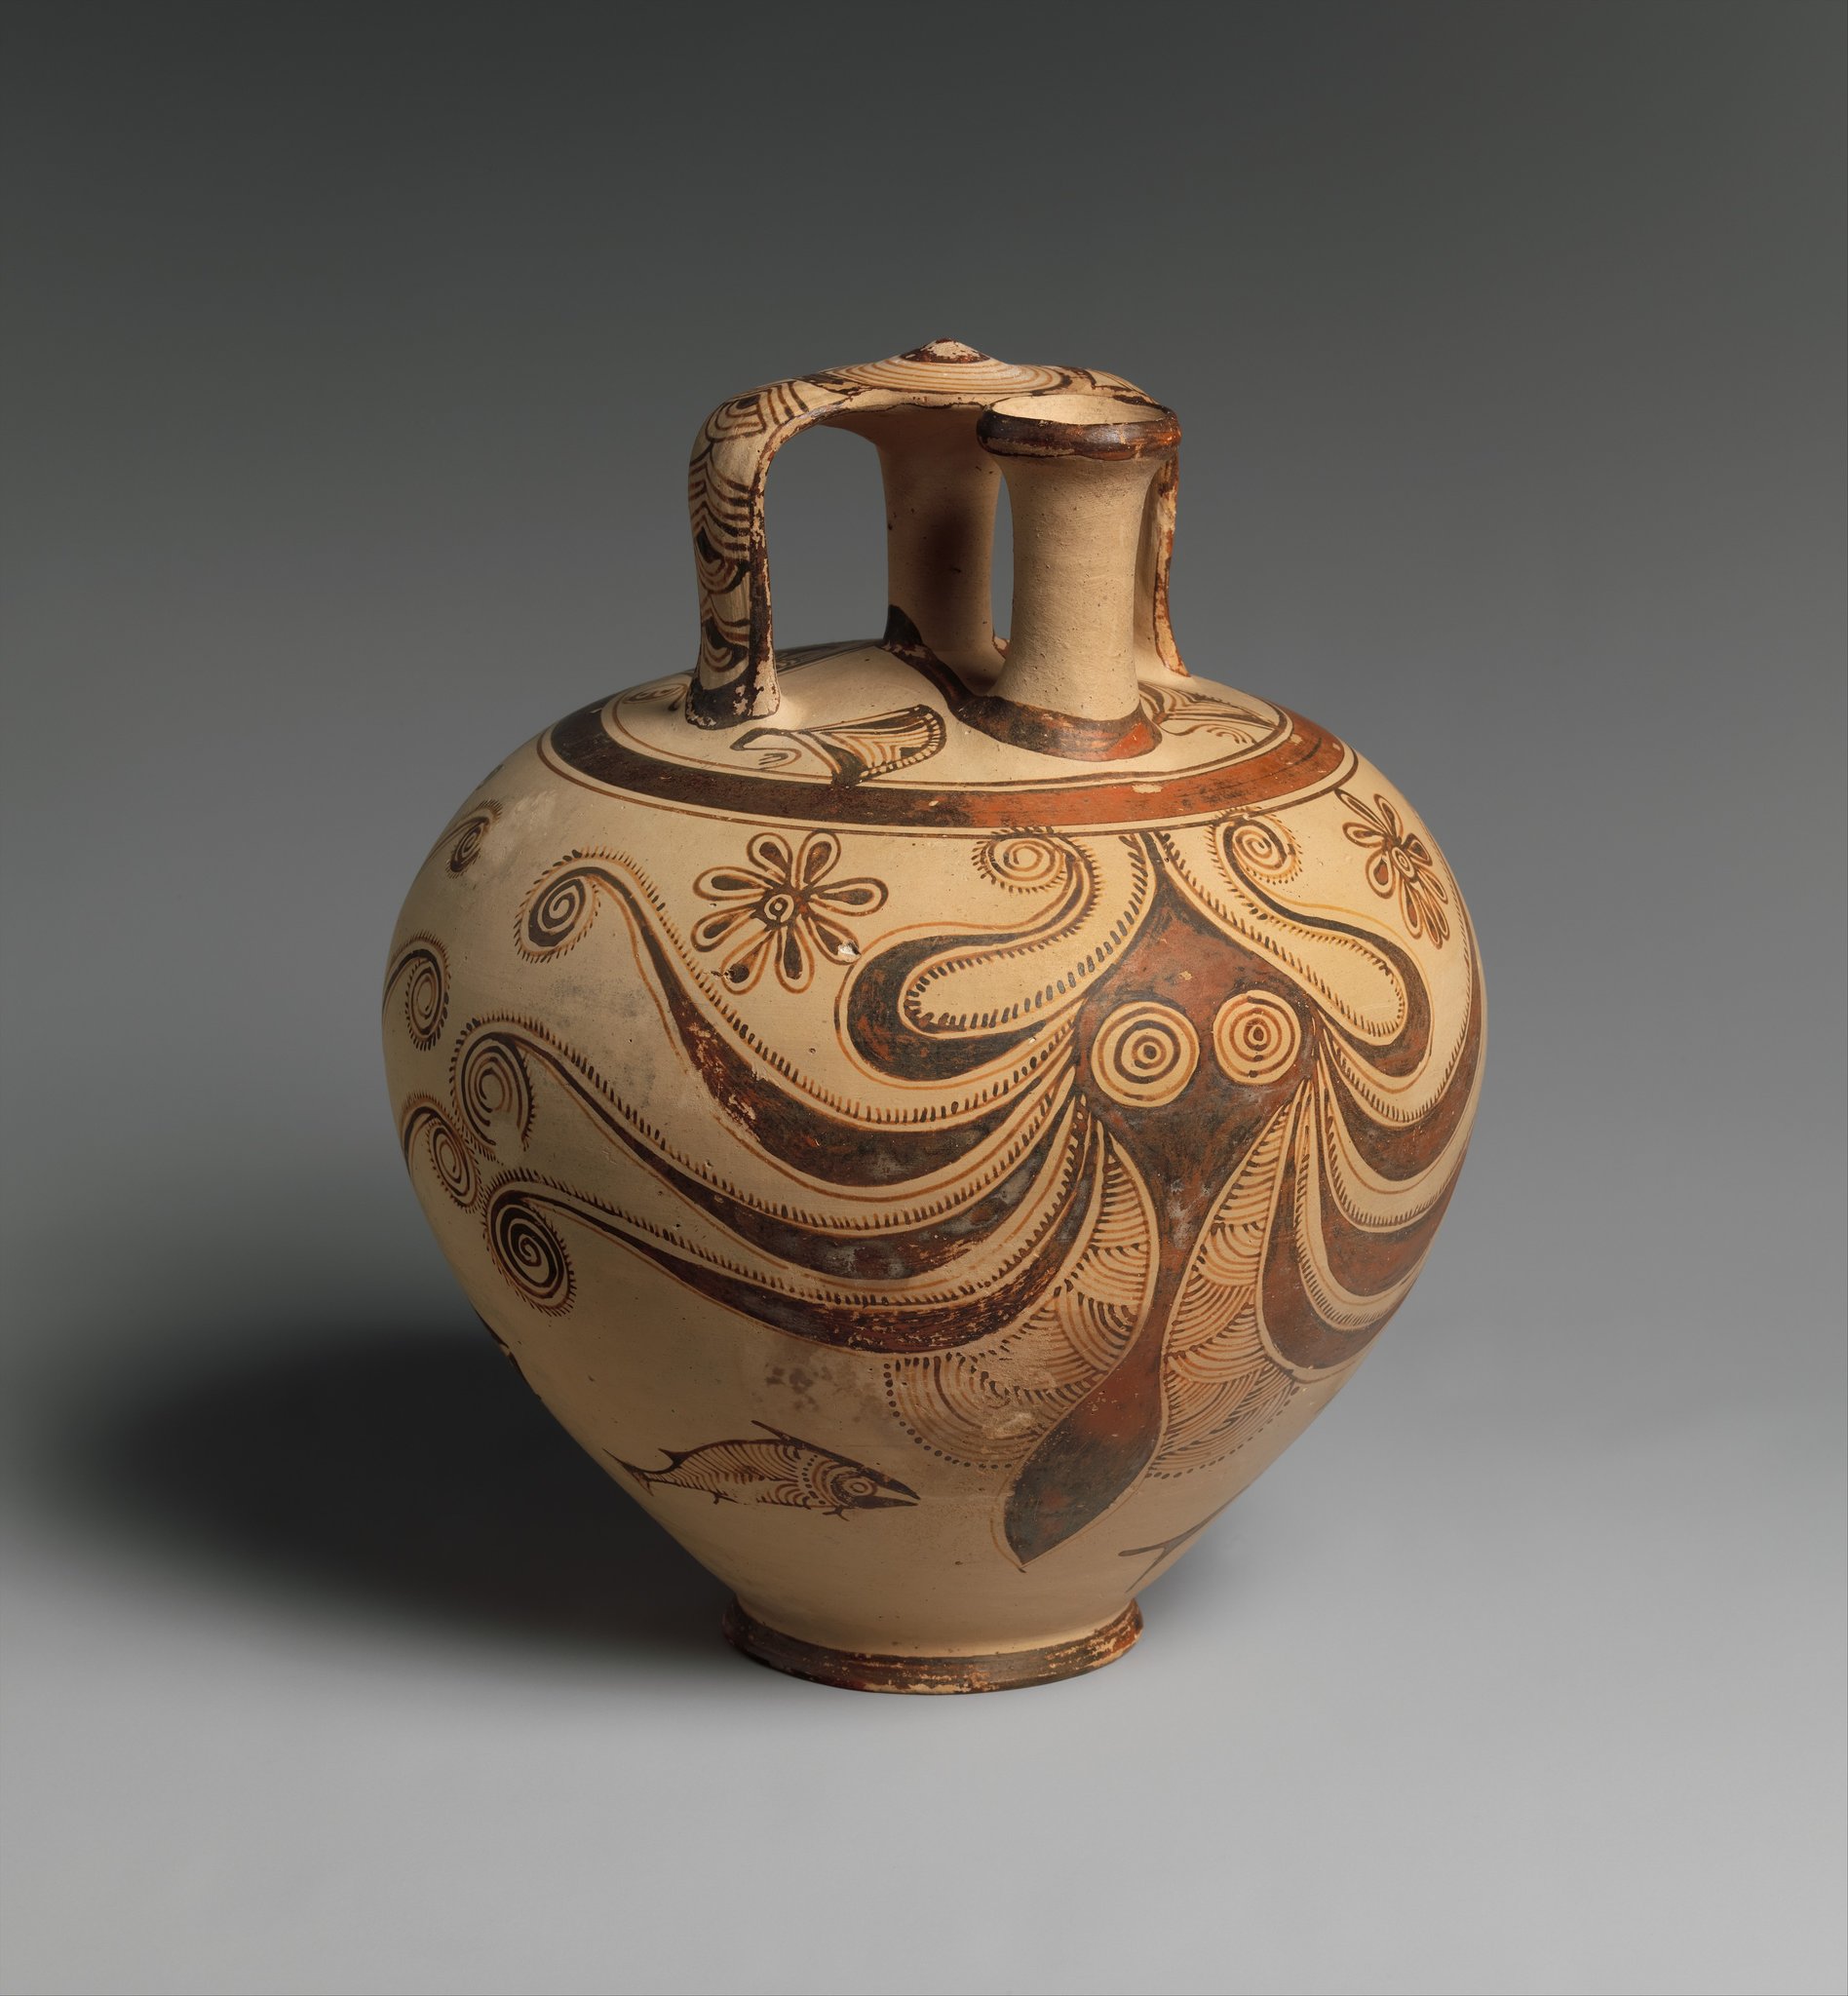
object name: stirrup jar with octopus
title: Terracotta stirrup jar with octopus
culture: aegean, helladic or mycenaean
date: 1200-1100 BCE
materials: terracotta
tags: fish,octopus